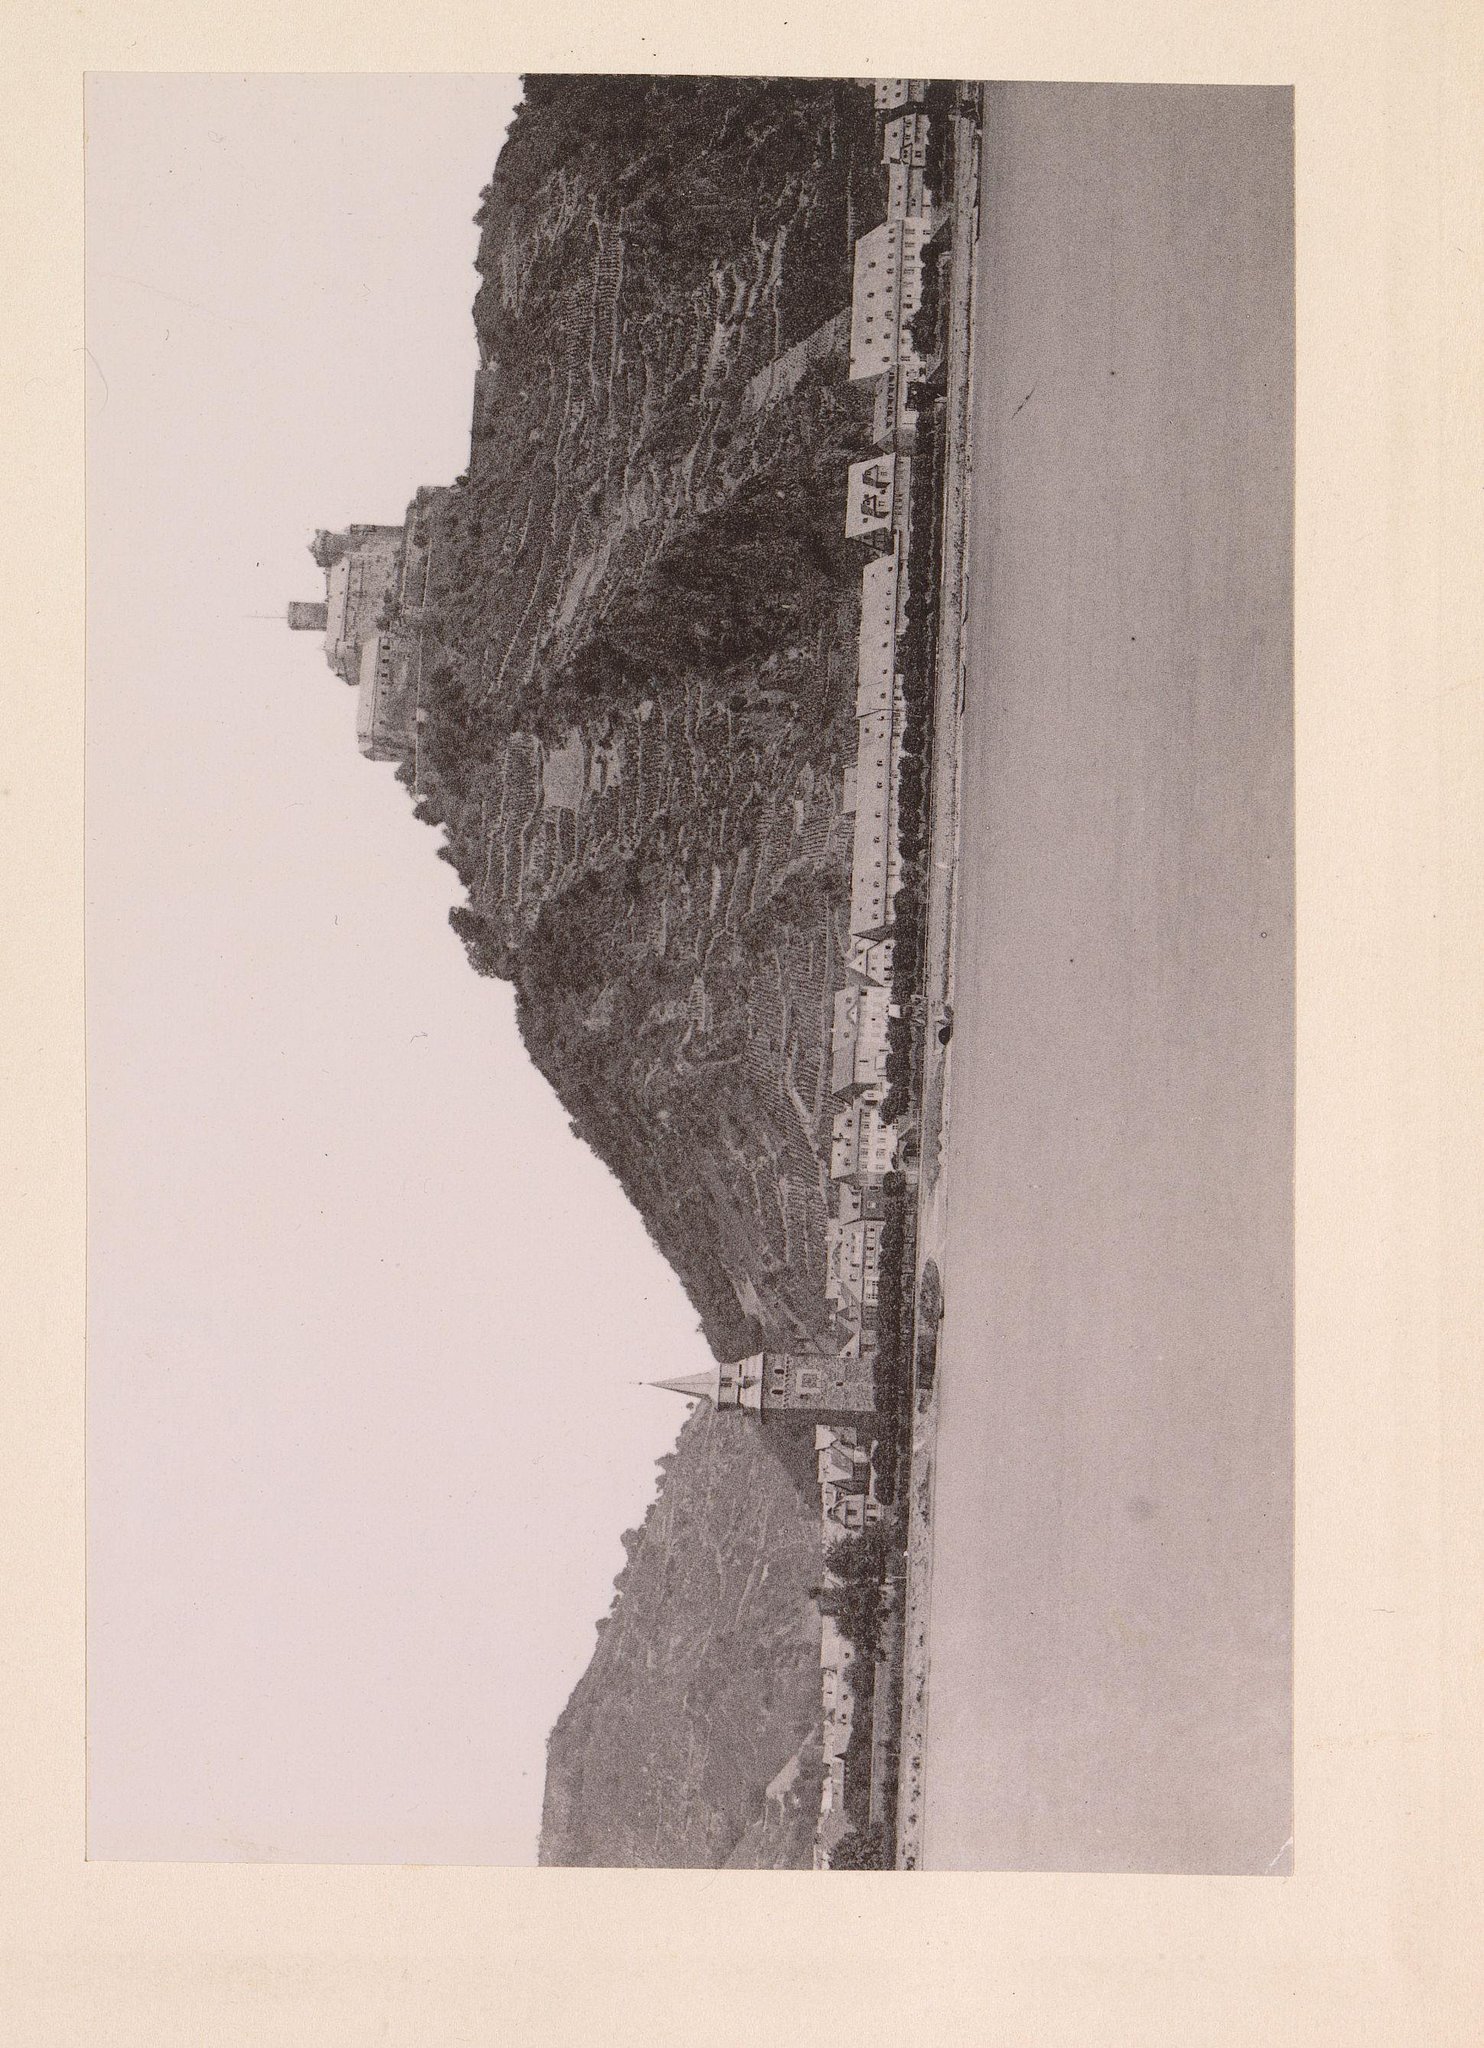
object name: photomechanical print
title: Gezicht op de Marksburg aan de Rijn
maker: Anonymous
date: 1881-1891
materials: paper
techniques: photograph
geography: rhineland-palatinate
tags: city-view, and landscape with man-made constructions, castle, river